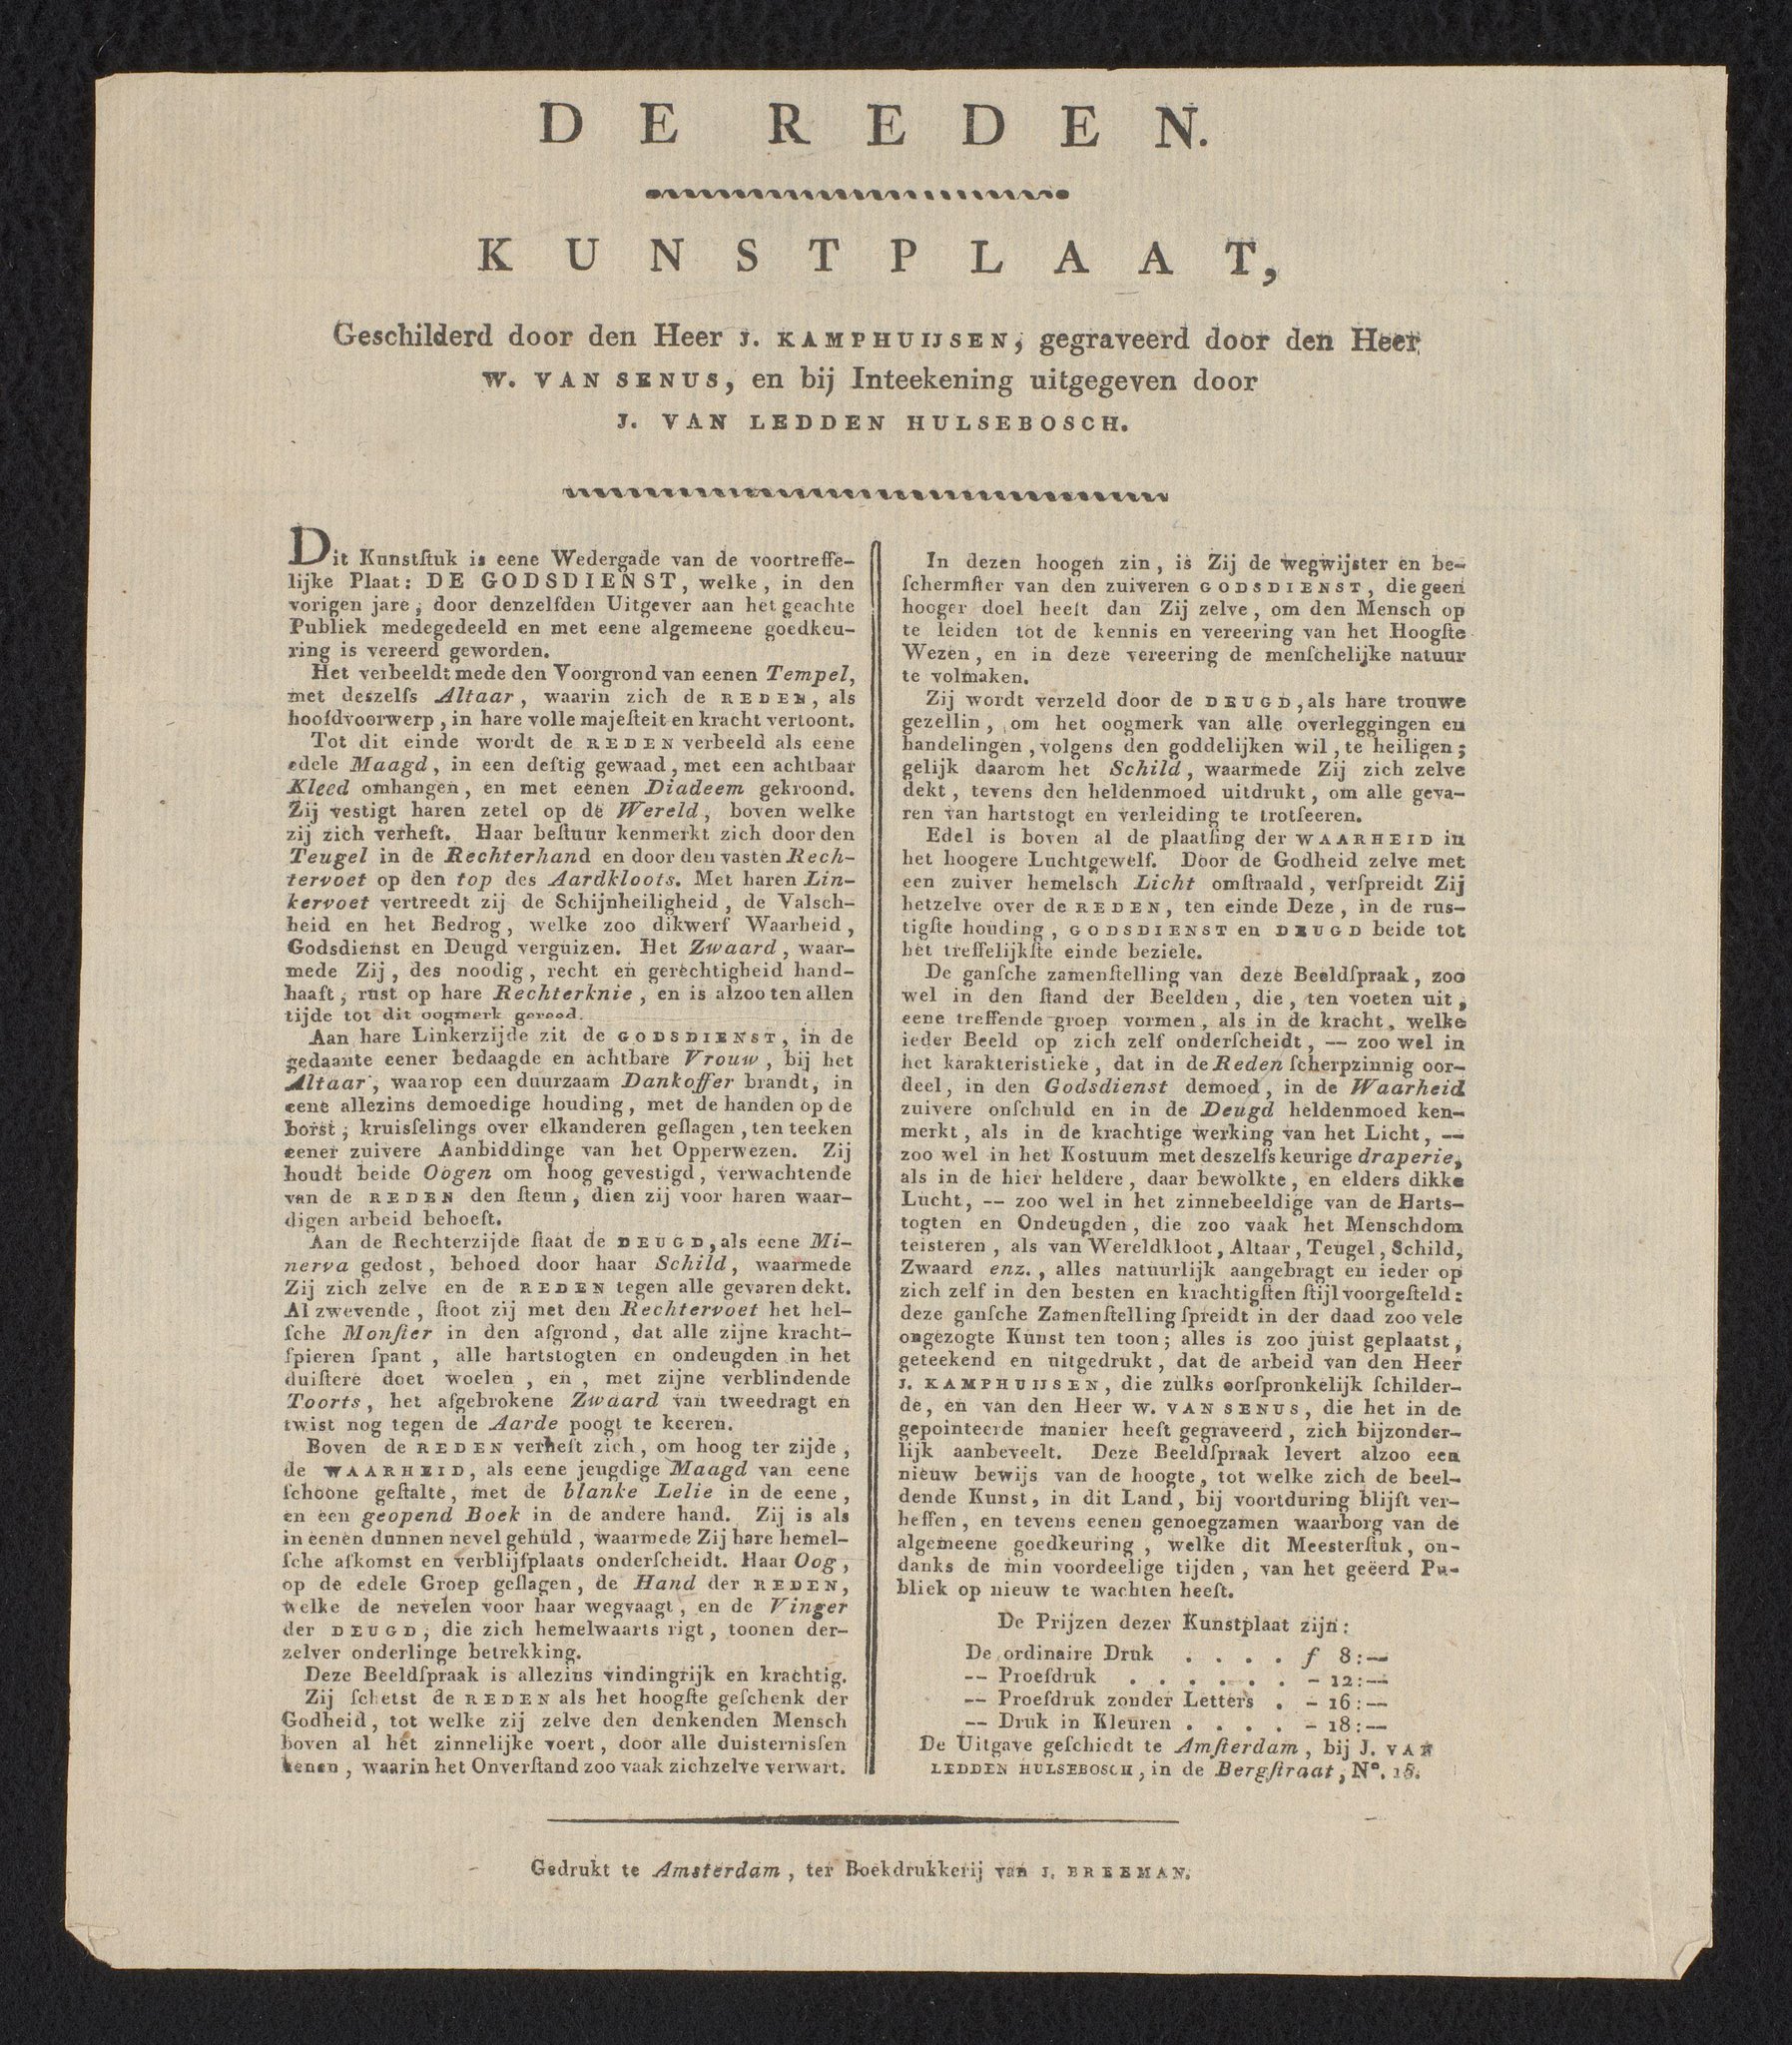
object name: print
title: Prospectus voor een allegorische voorstelling van de Rede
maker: j. van ledden hulsebosch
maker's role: bookseller, publisher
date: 1802-1819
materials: paper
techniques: letterpress printing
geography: amsterdam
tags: printed matter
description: Prospectus voor de prent 'De Reden', gegraveerd door Willem van Senus naar een schilderij van Jan Kamphuijsen. Zie RP-P-1904-4054 voor een proefdruk van deze prent.